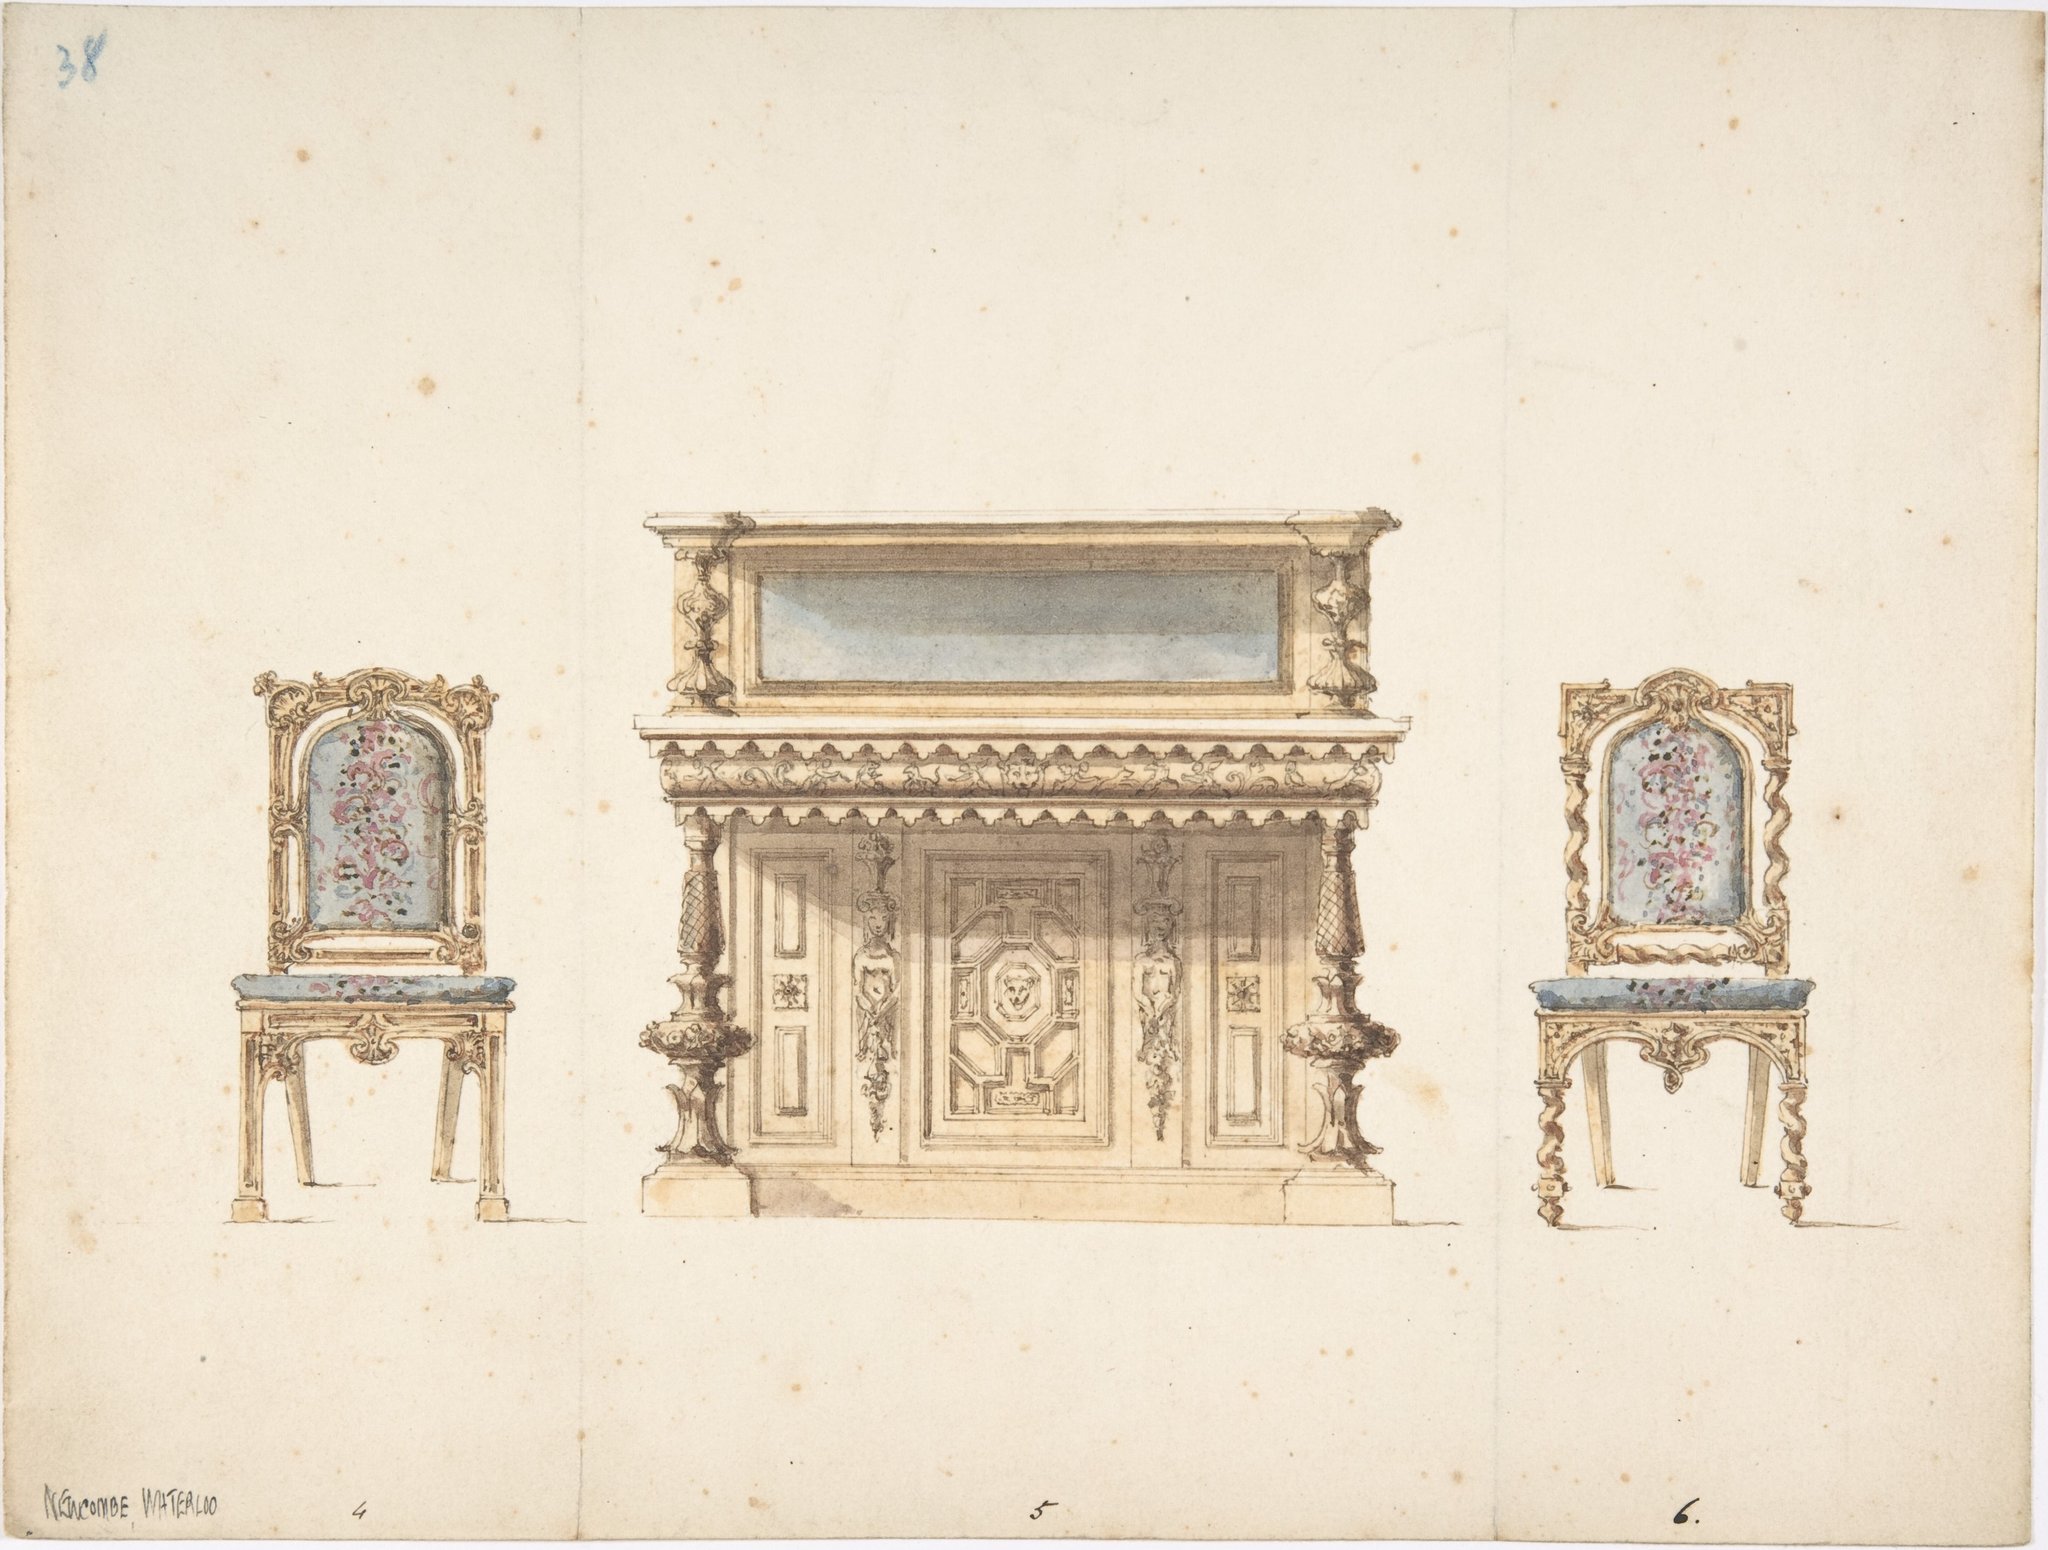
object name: drawing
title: Design for a Mirrored Cabinet and Two Chairs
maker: anonymous, british, 19th century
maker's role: artist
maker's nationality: british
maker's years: 1800-1900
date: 1801-1833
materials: ink, watercolor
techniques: brush, pen, wash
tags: human figures,animals,chairs,cabinets